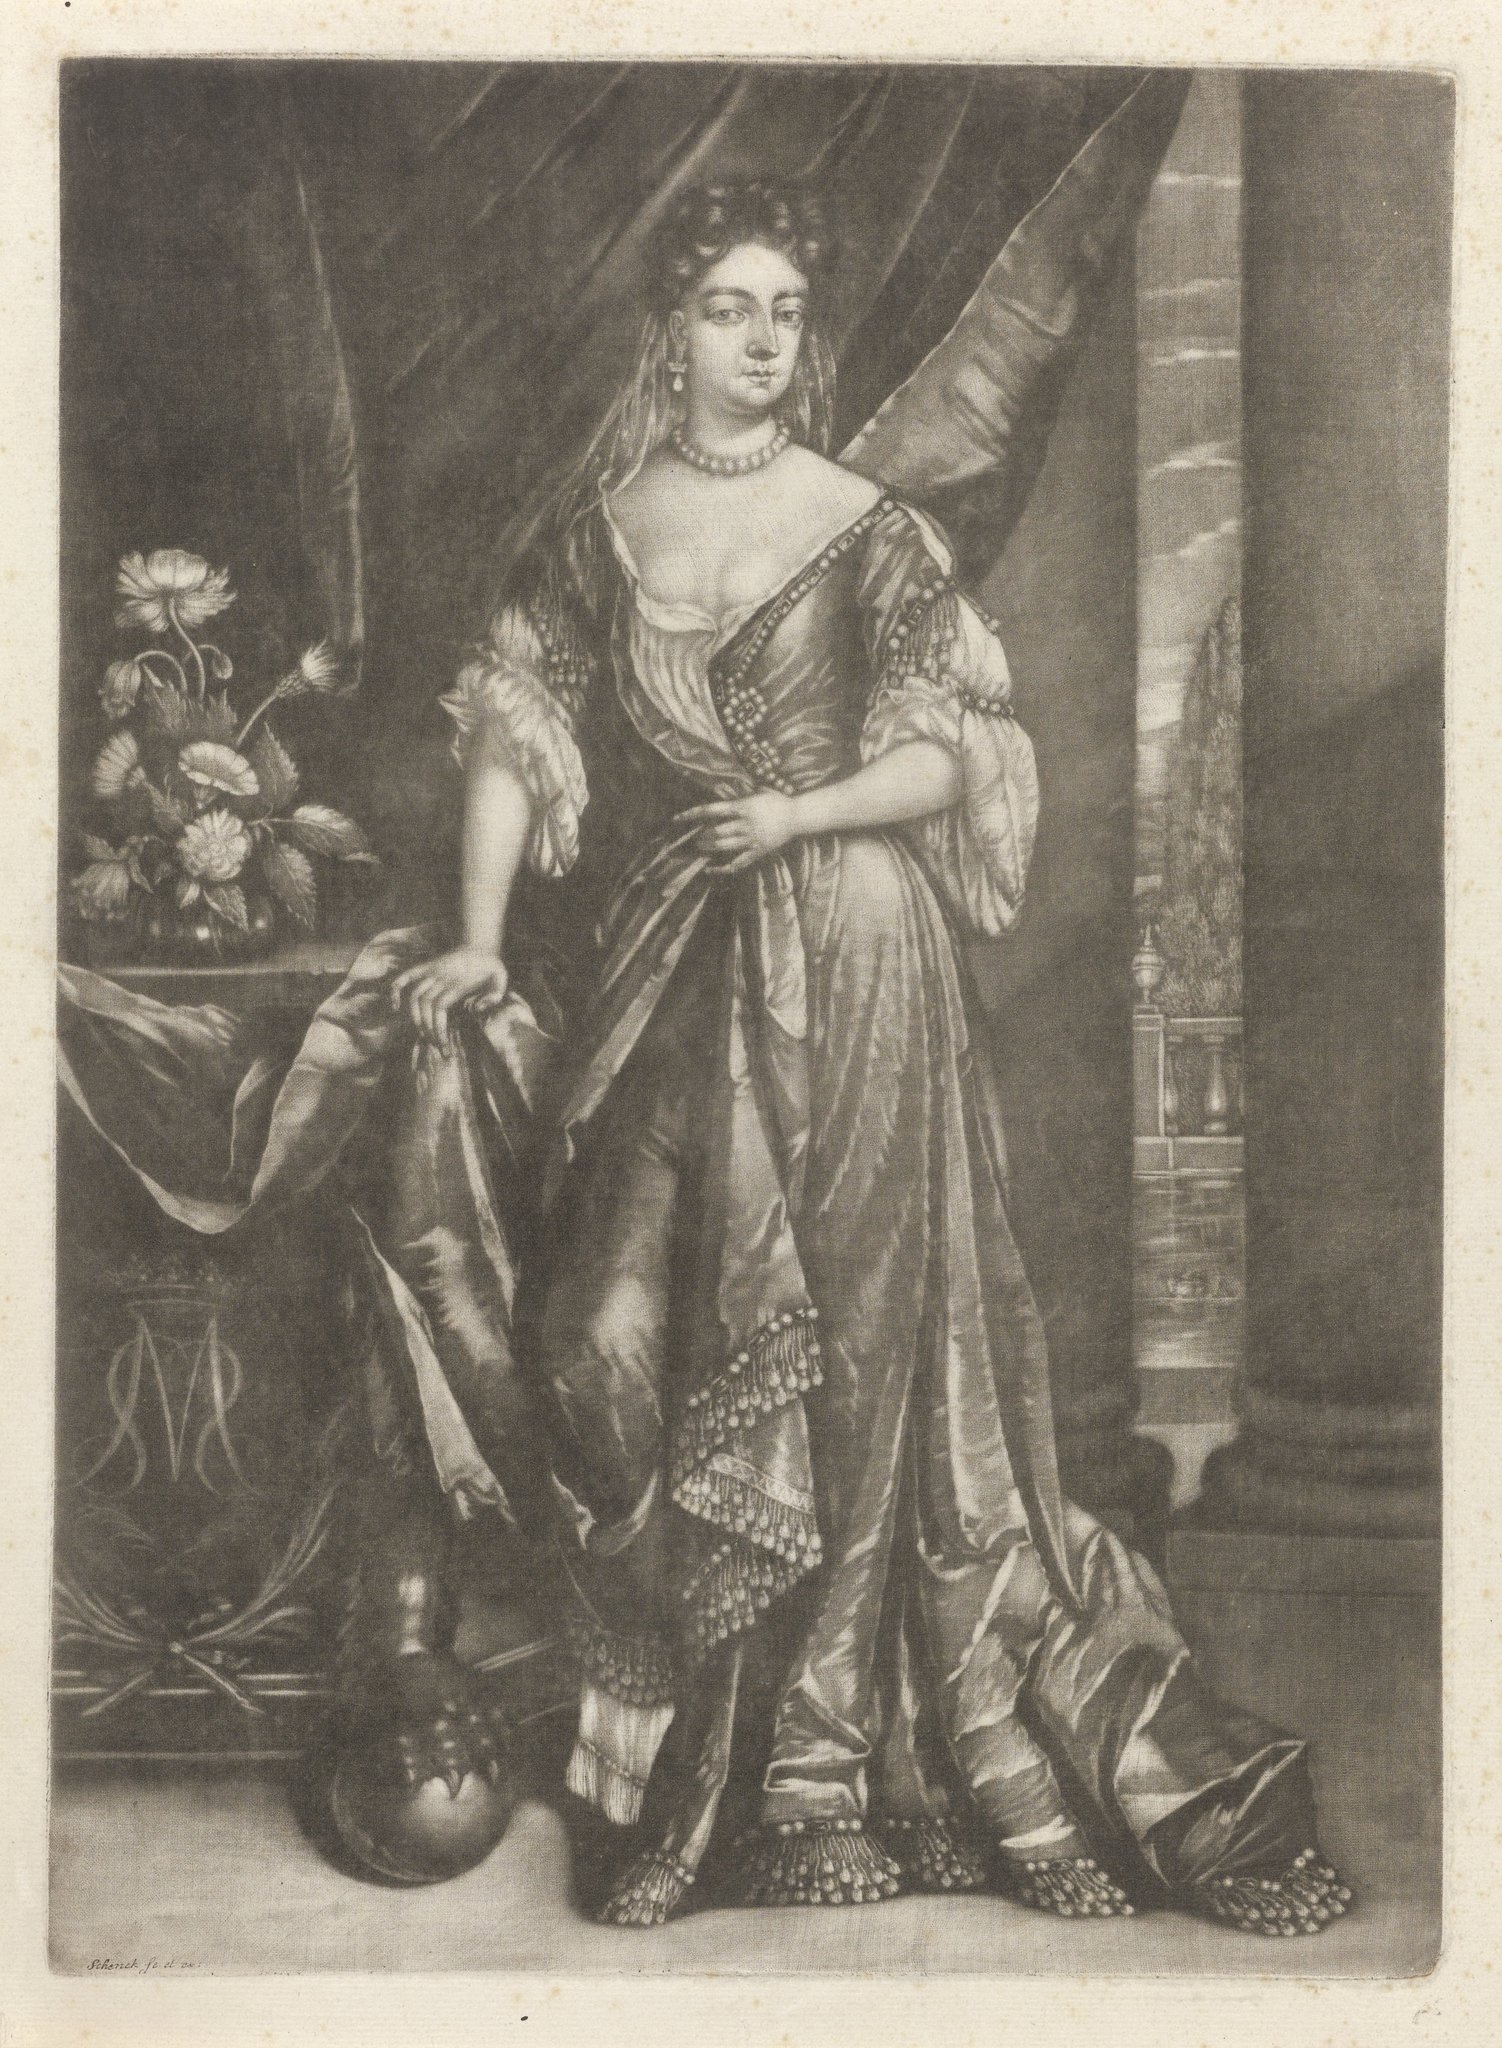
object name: print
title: Portret van Maria II Stuart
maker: pieter schenk (i)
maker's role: print maker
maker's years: 1660-1711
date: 1688-1711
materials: paper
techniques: mezzotint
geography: amsterdam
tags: maria ii stuart (koningin van engeland, schotland en ierland)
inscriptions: collector's mark: Lugt 2228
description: Portret van Maria II. Ze staat naast een tafel met daarop een vaas.